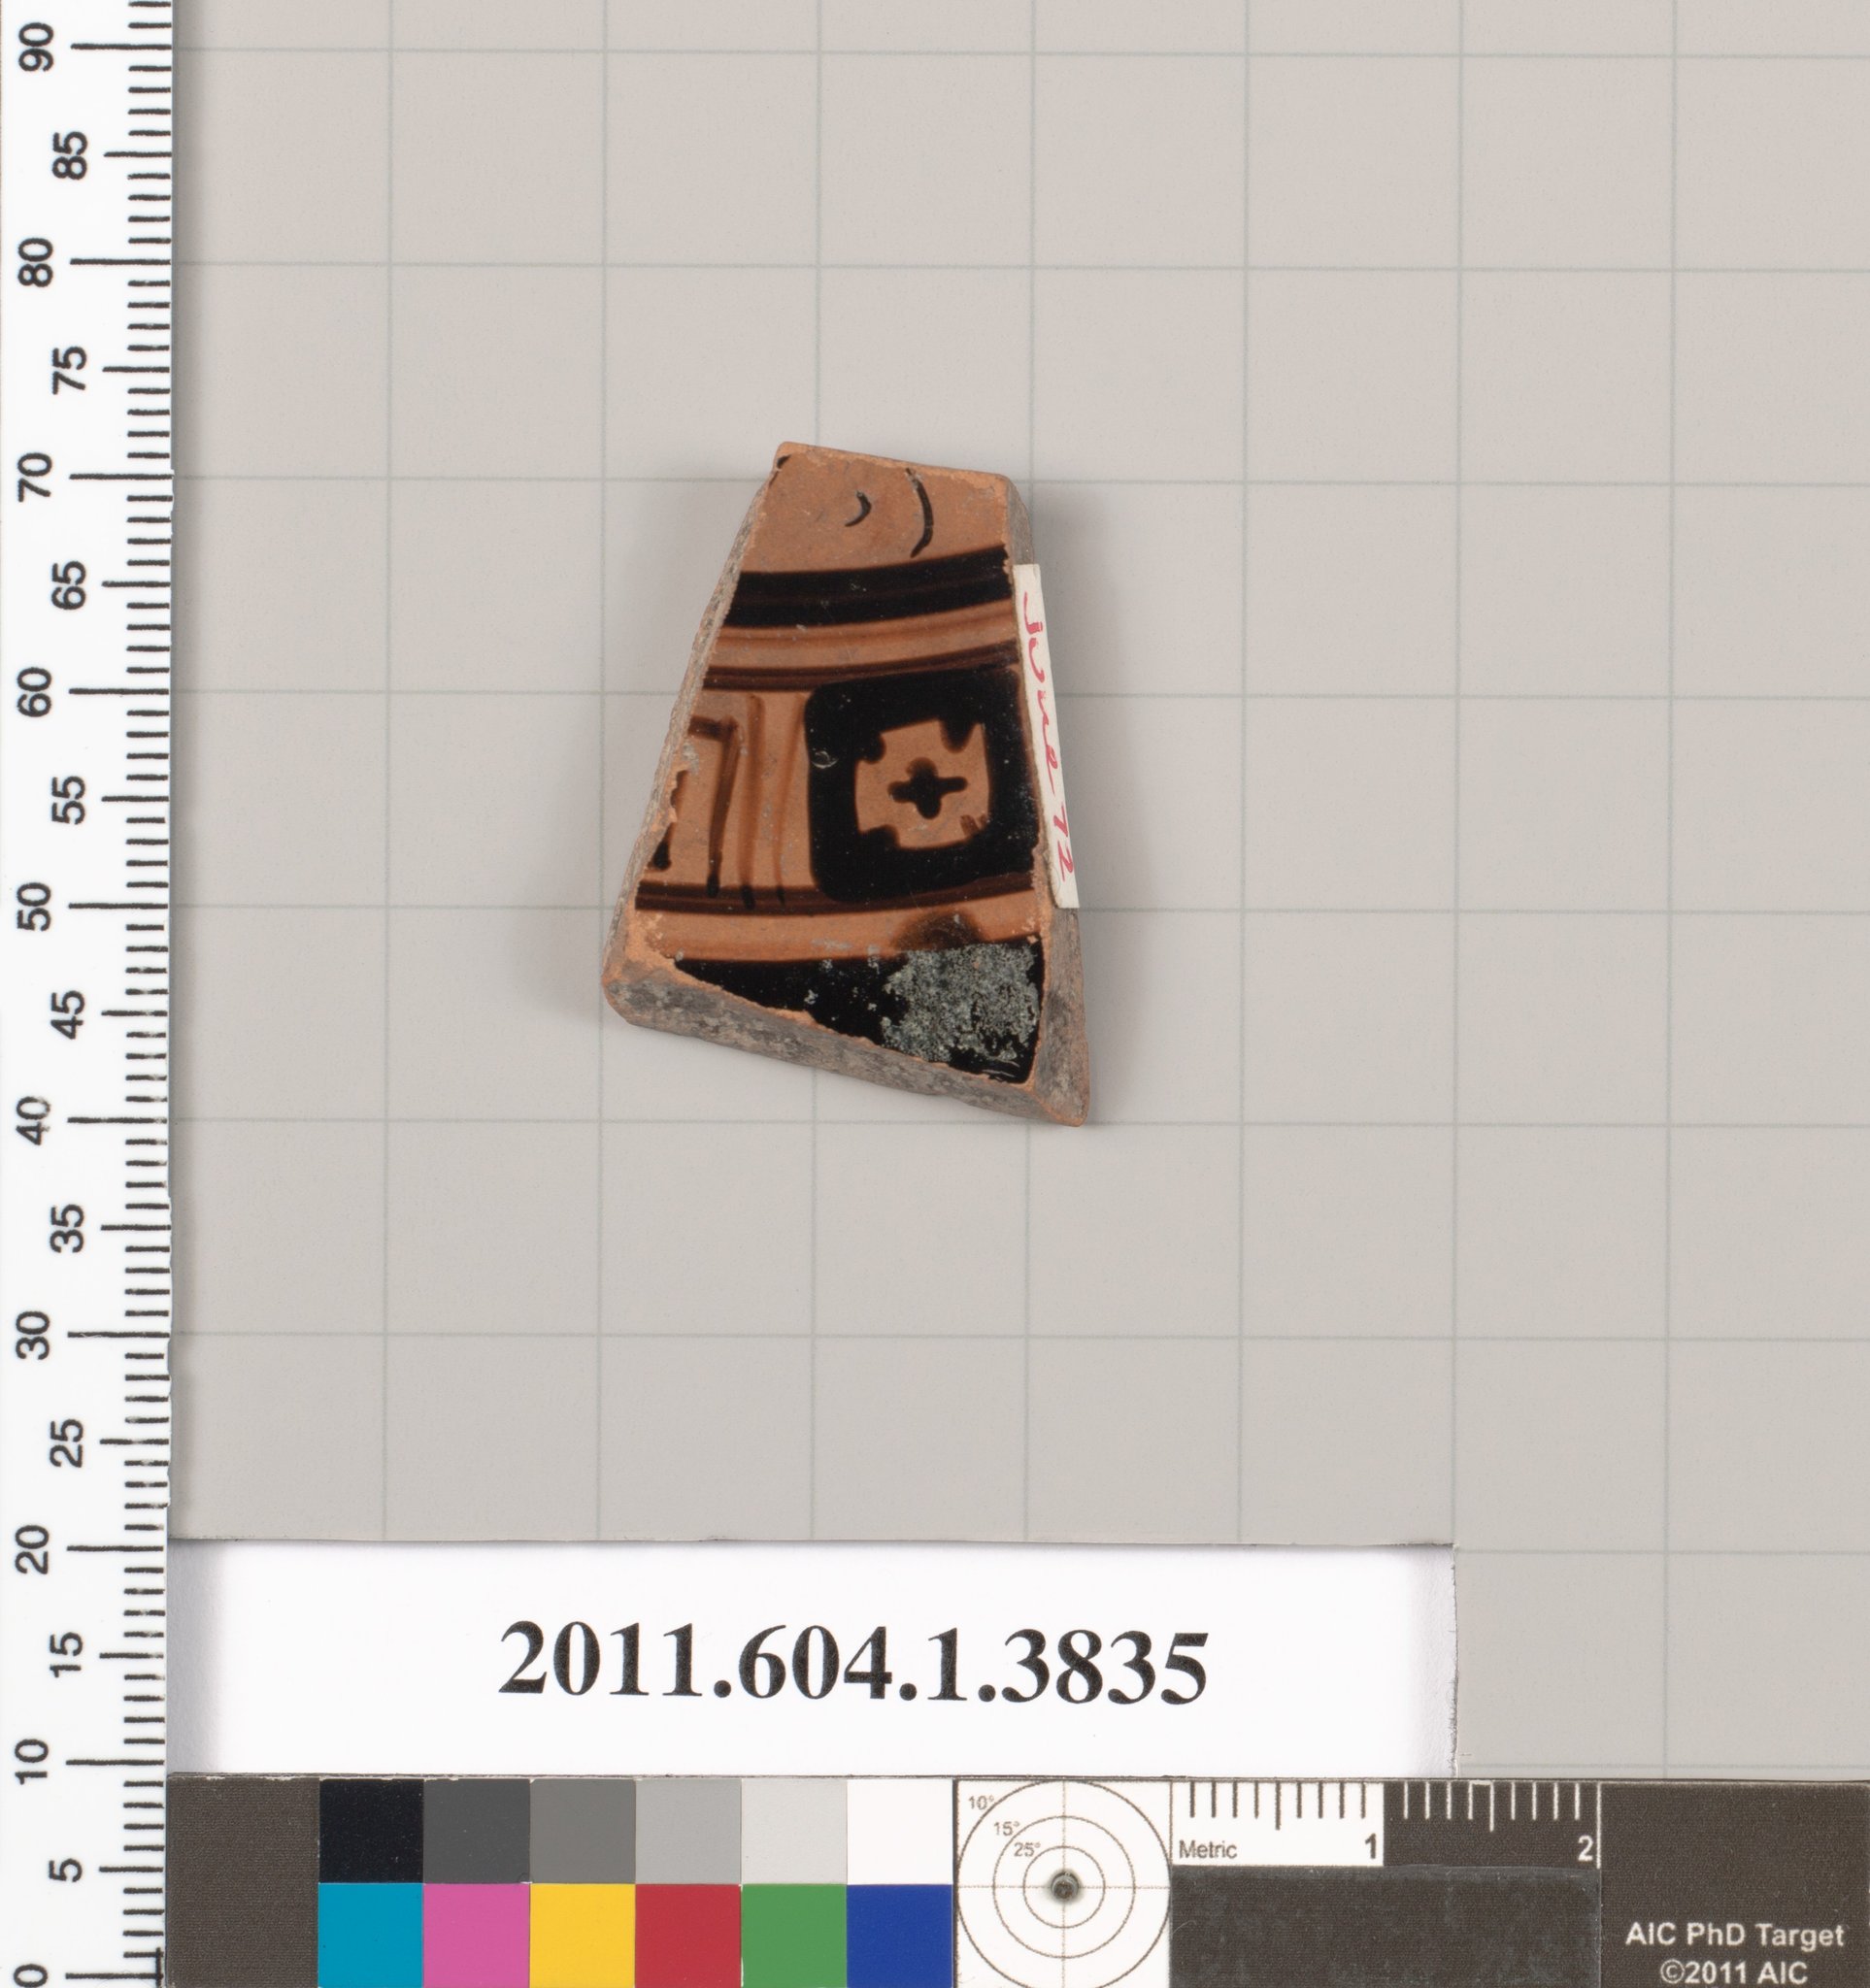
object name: kylix fragment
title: Terracotta fragment of a kylix (drinking cup)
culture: greek, attic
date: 475-451 BCE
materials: terracotta